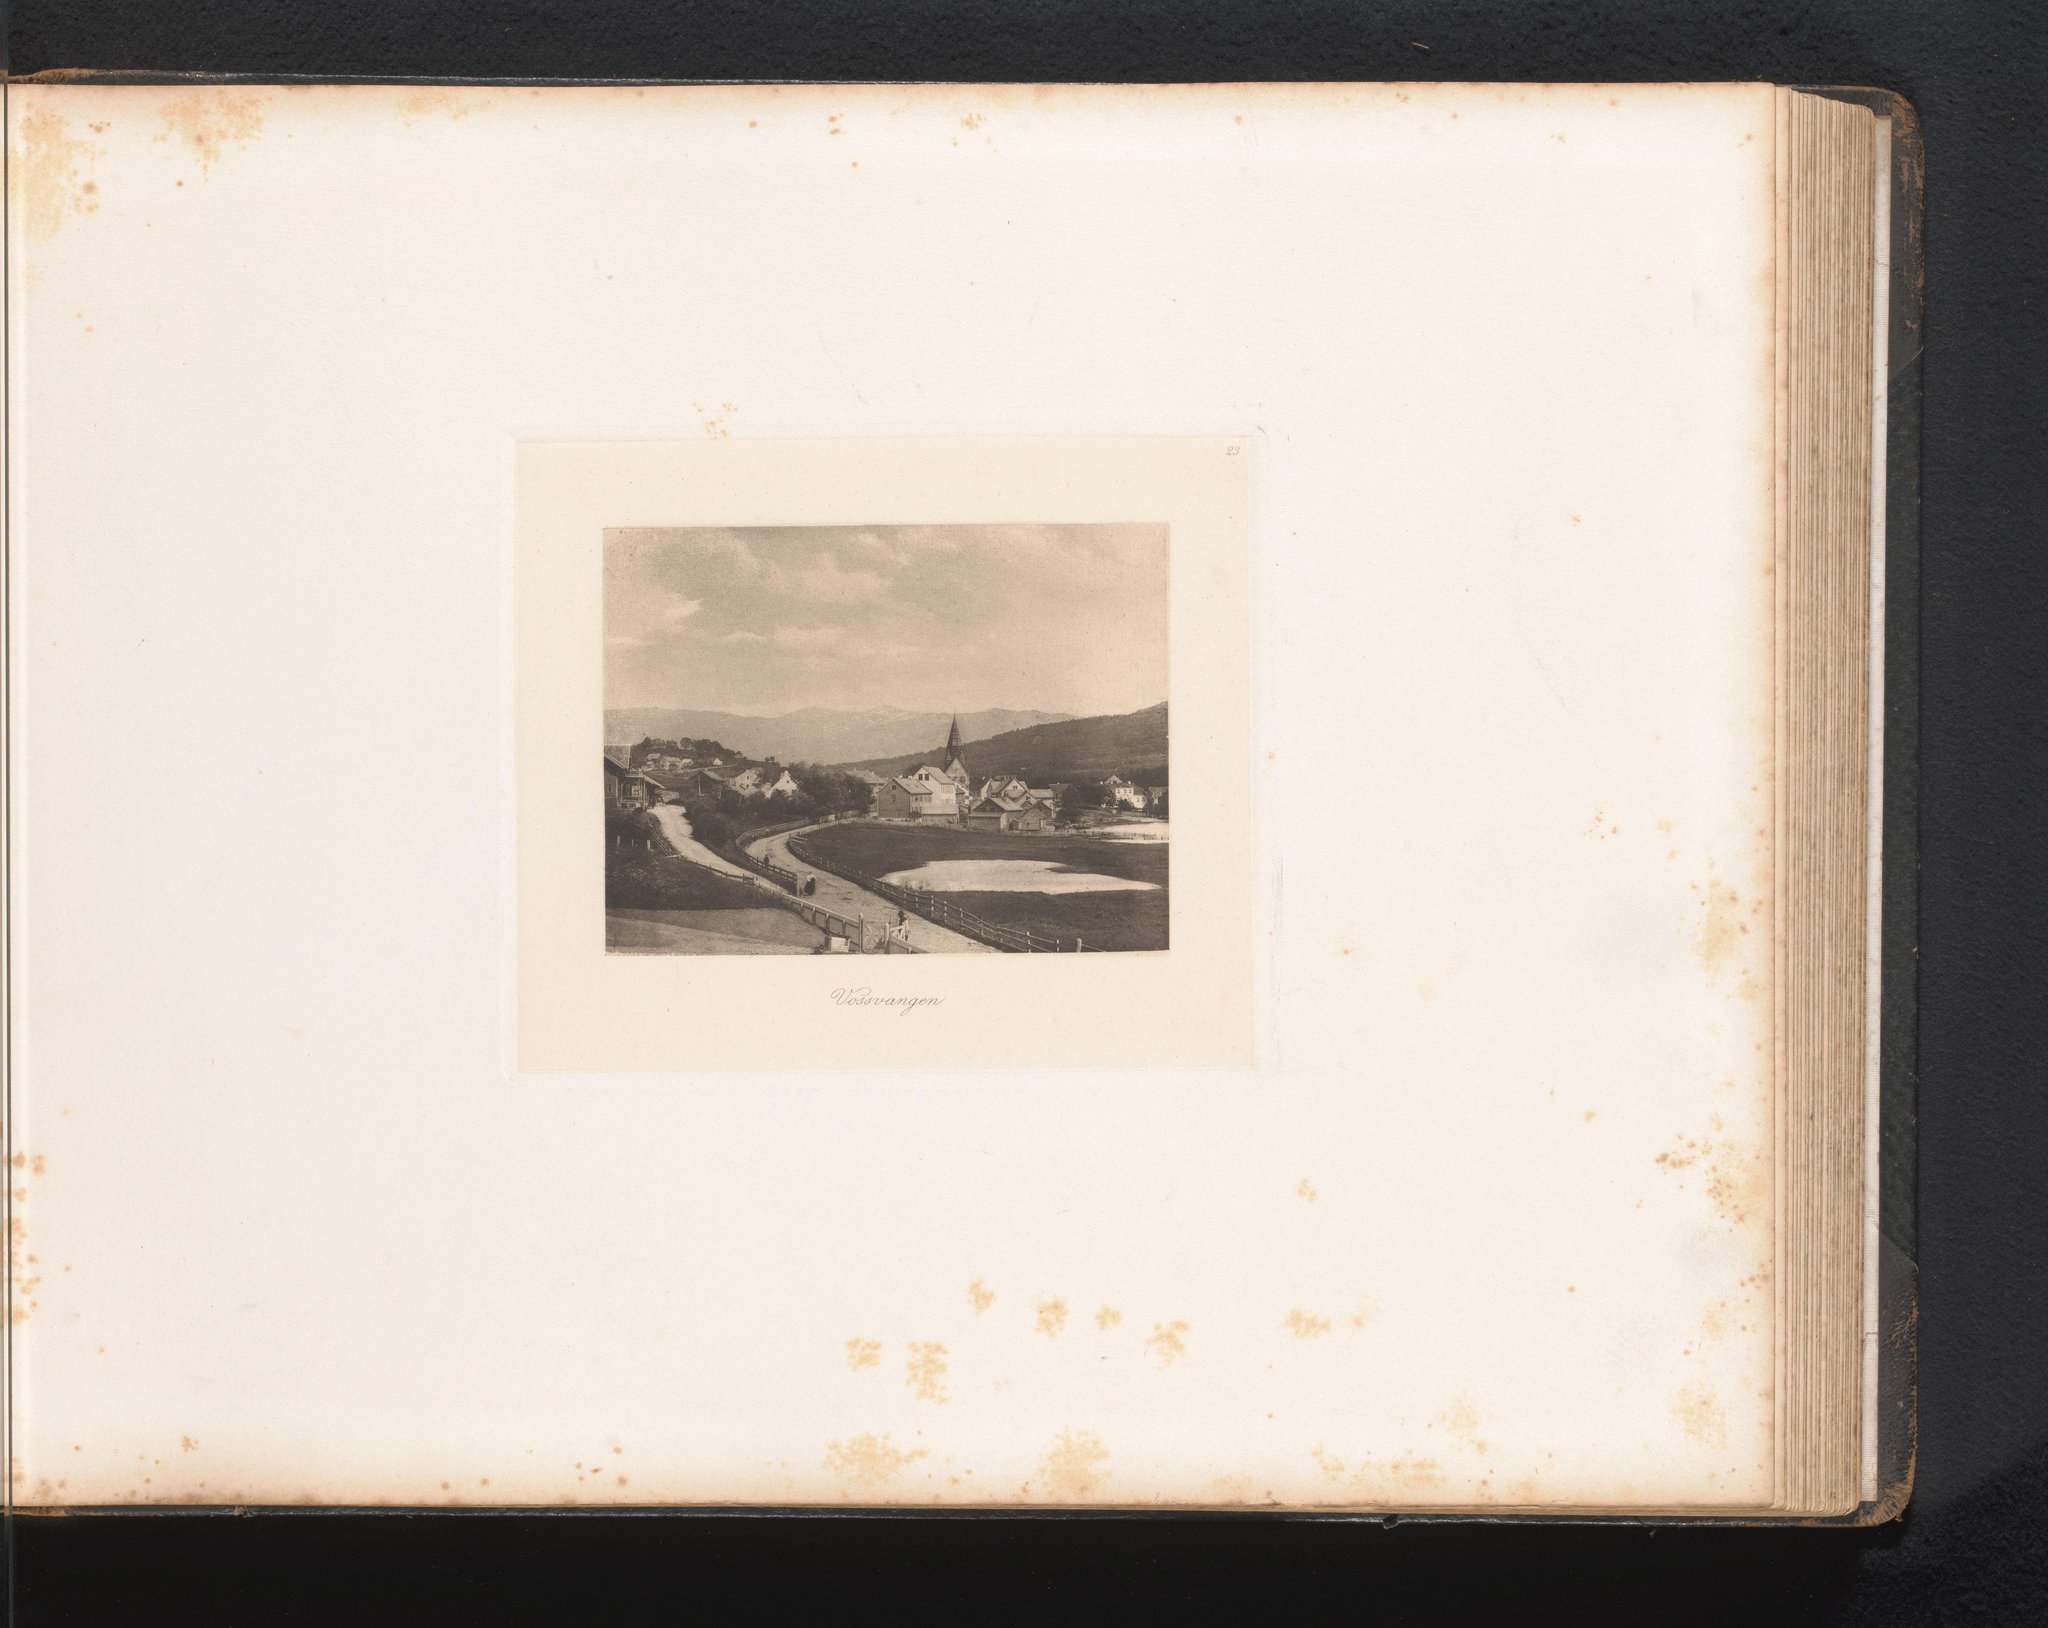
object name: page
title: Vossvangen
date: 1888-1893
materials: paper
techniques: photograph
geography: vienna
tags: city-view in general; 'veduta' (+ city(-scape) with figures, staffage)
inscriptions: number: ‘23’